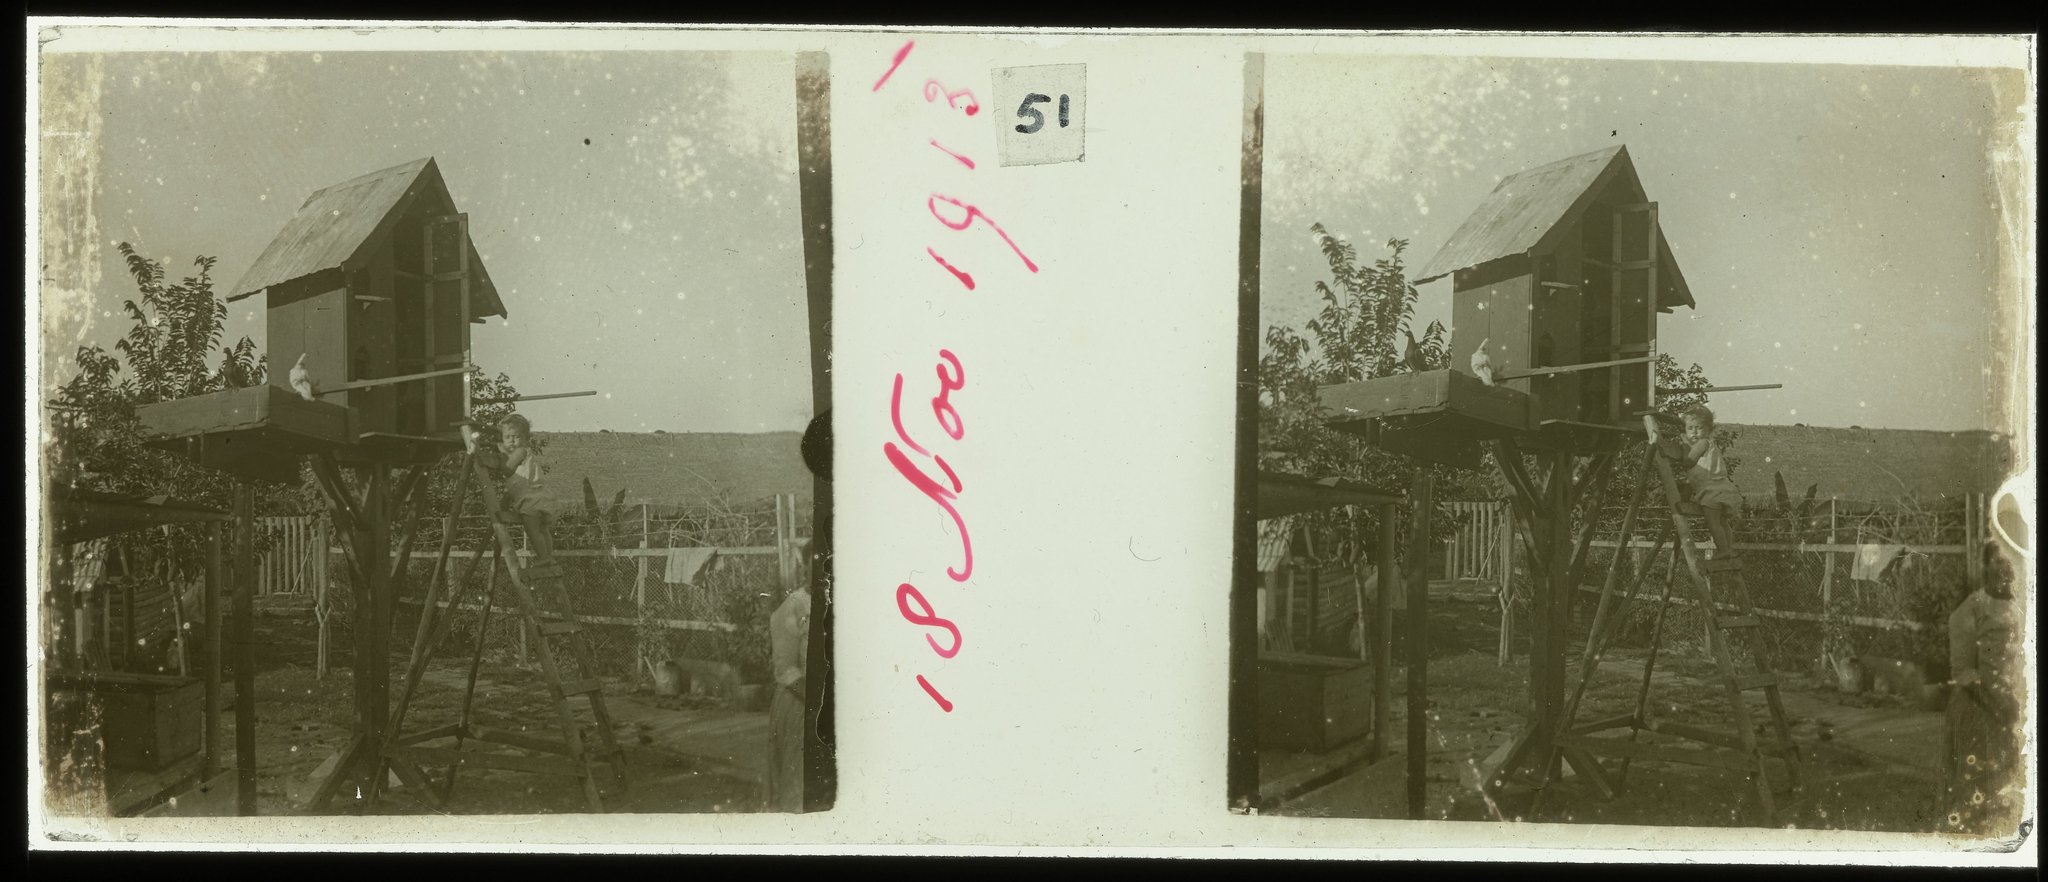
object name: stereograph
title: Gerard Brouwers bij het duivenhok op plantage Accaribo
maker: theodoor brouwers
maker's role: amateurfotograaf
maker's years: 1874-1932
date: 1913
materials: glass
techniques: photography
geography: suriname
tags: amsterdam, theodoor brouwers, plantation, suriname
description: In de periode 1911-1932 woonde op plantage Accaribo in Suriname de familie Brouwers van wie de foto's afkomstig zijn. Rond 1910 vond Theodoor Brouwers werk op plantage Accaribo. In 1929 werd hij eigenaar van de plantage. Op Accaribo werden in zijn tijd bananen geproduceerd en wat koffie.